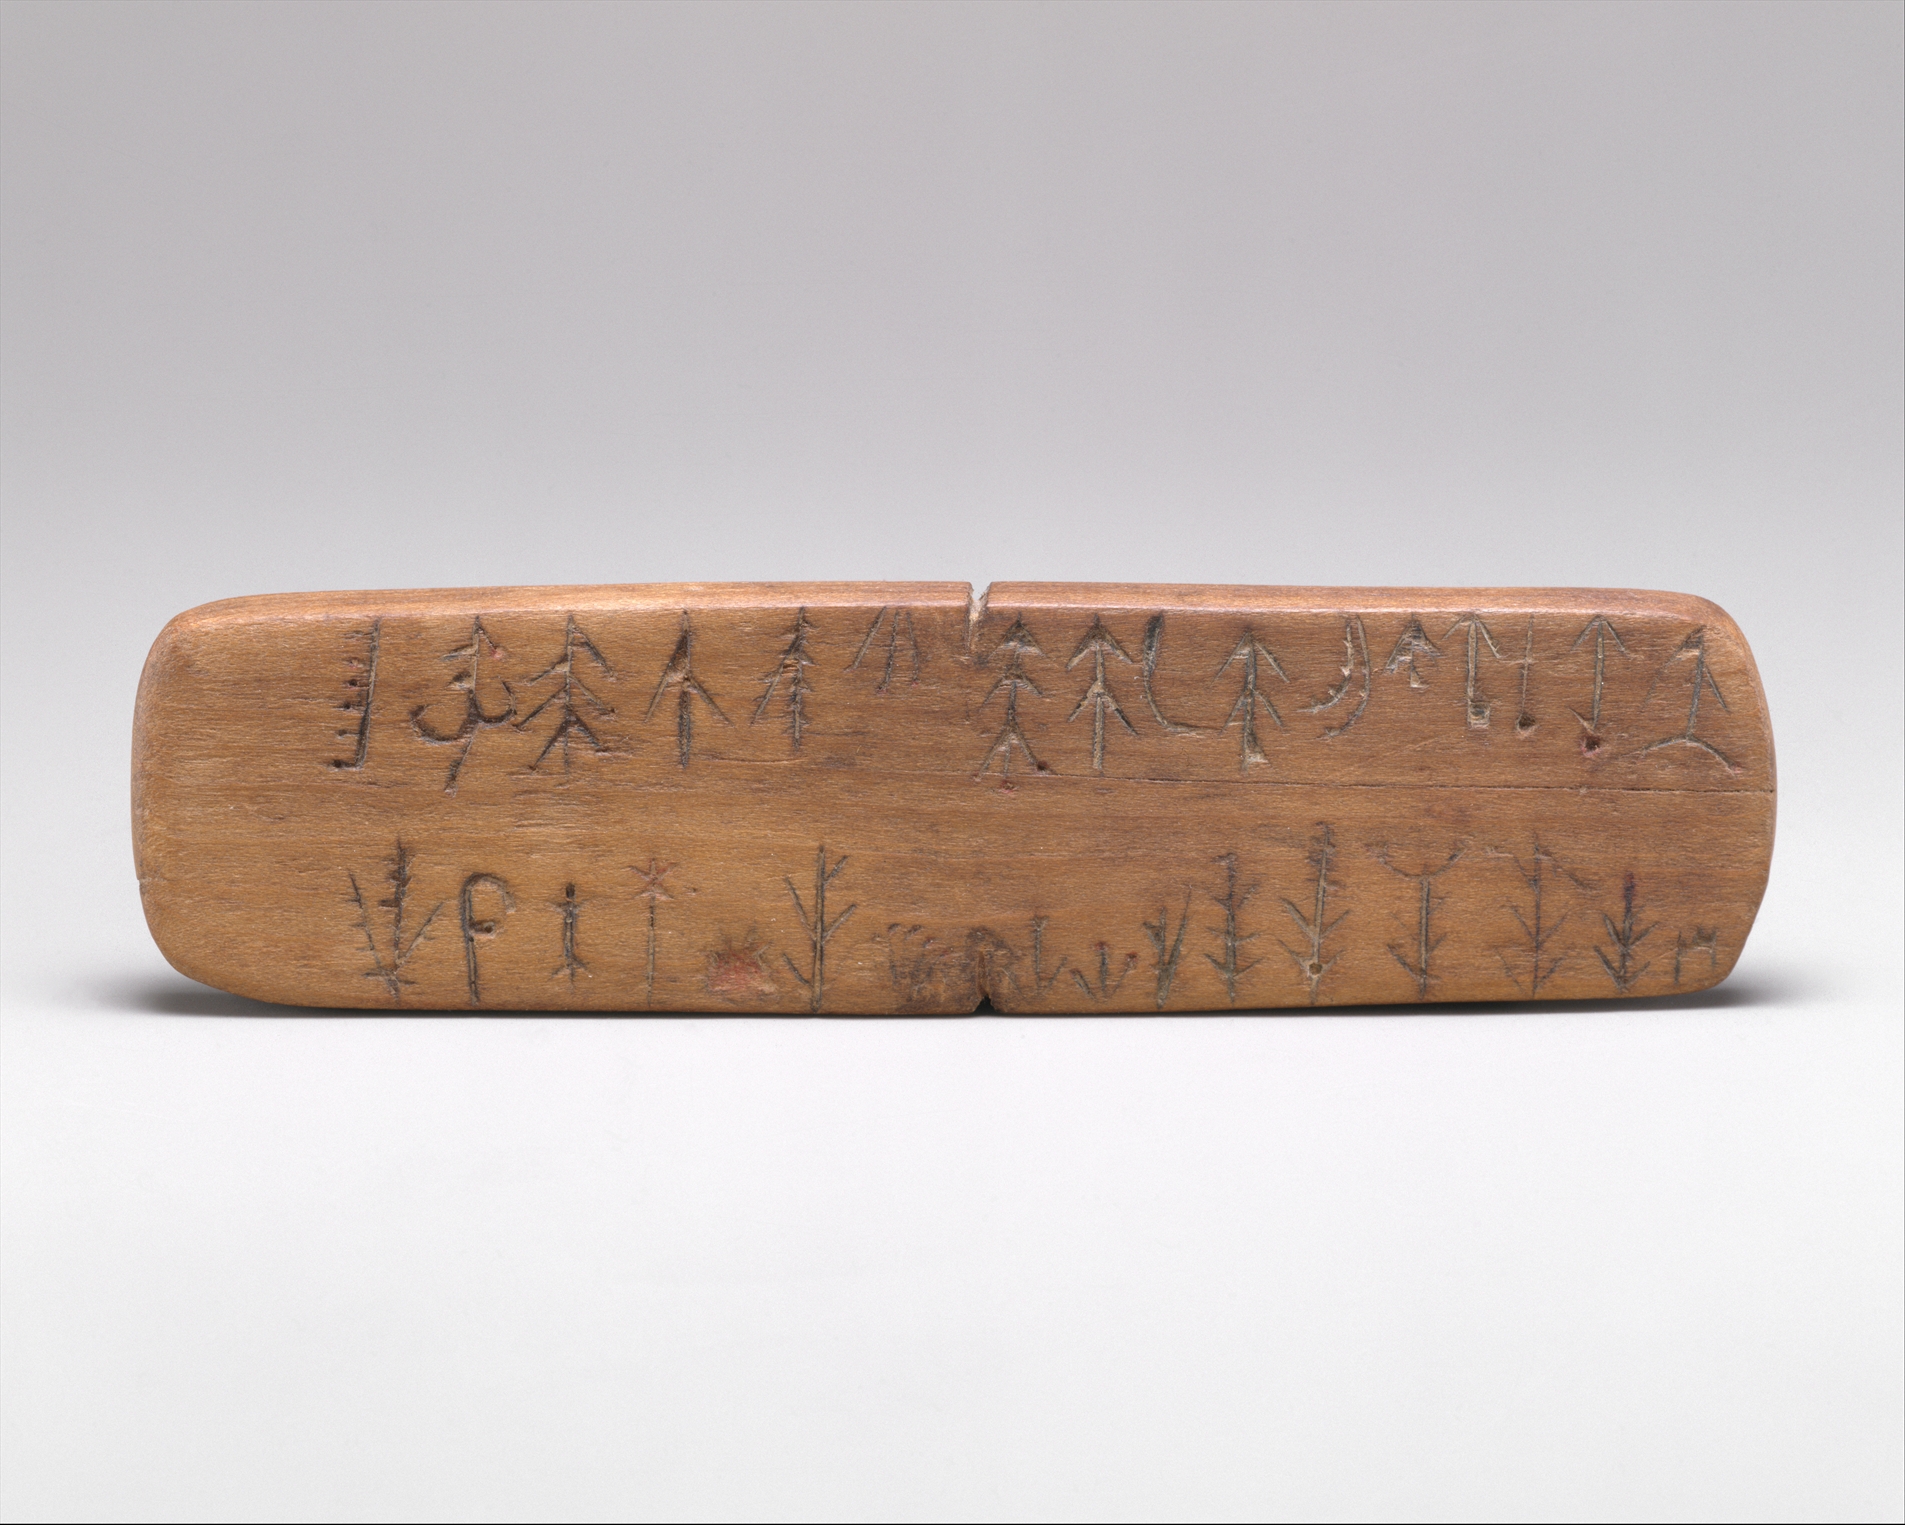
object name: prescription stick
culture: prairie potawatomi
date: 1801-1833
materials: pigment, wood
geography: united states